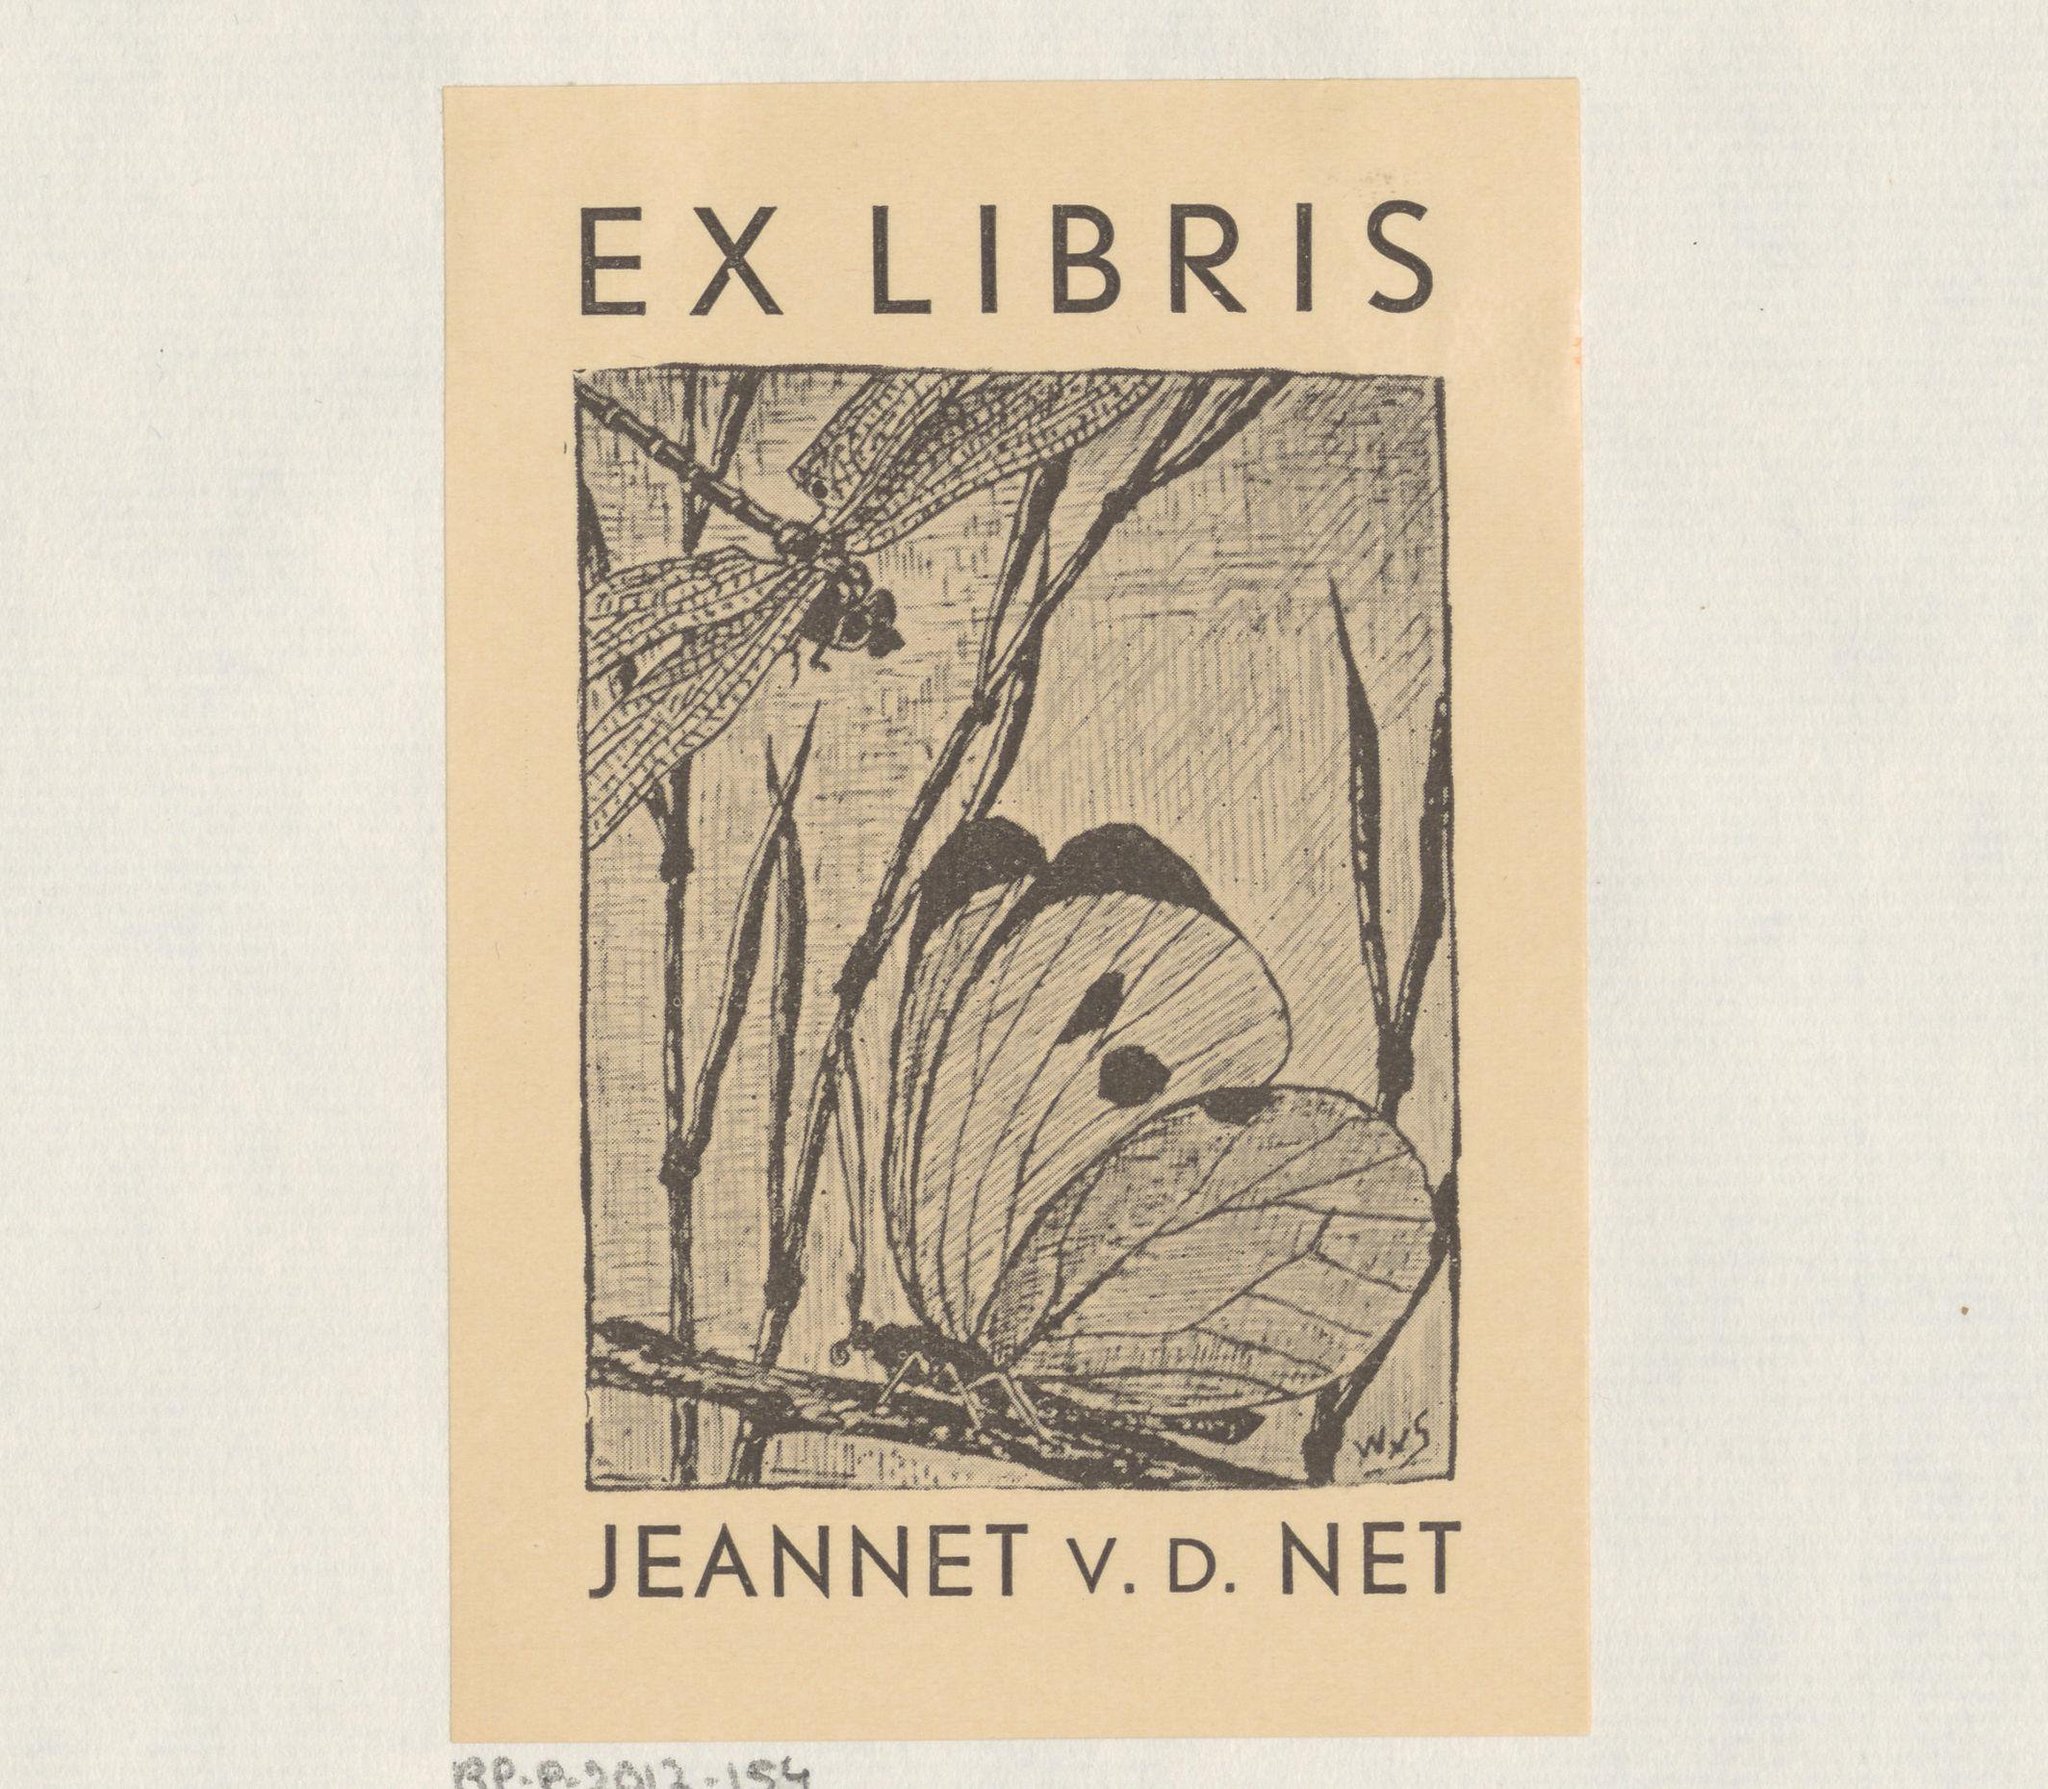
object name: bookplate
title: Ex libris van Jeannet v.d. Net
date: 1900-1999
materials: paper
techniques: printing block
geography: netherlands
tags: insects: dragon-fly, insects: butterfly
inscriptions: signature: ‘Cl / W v Spijk’